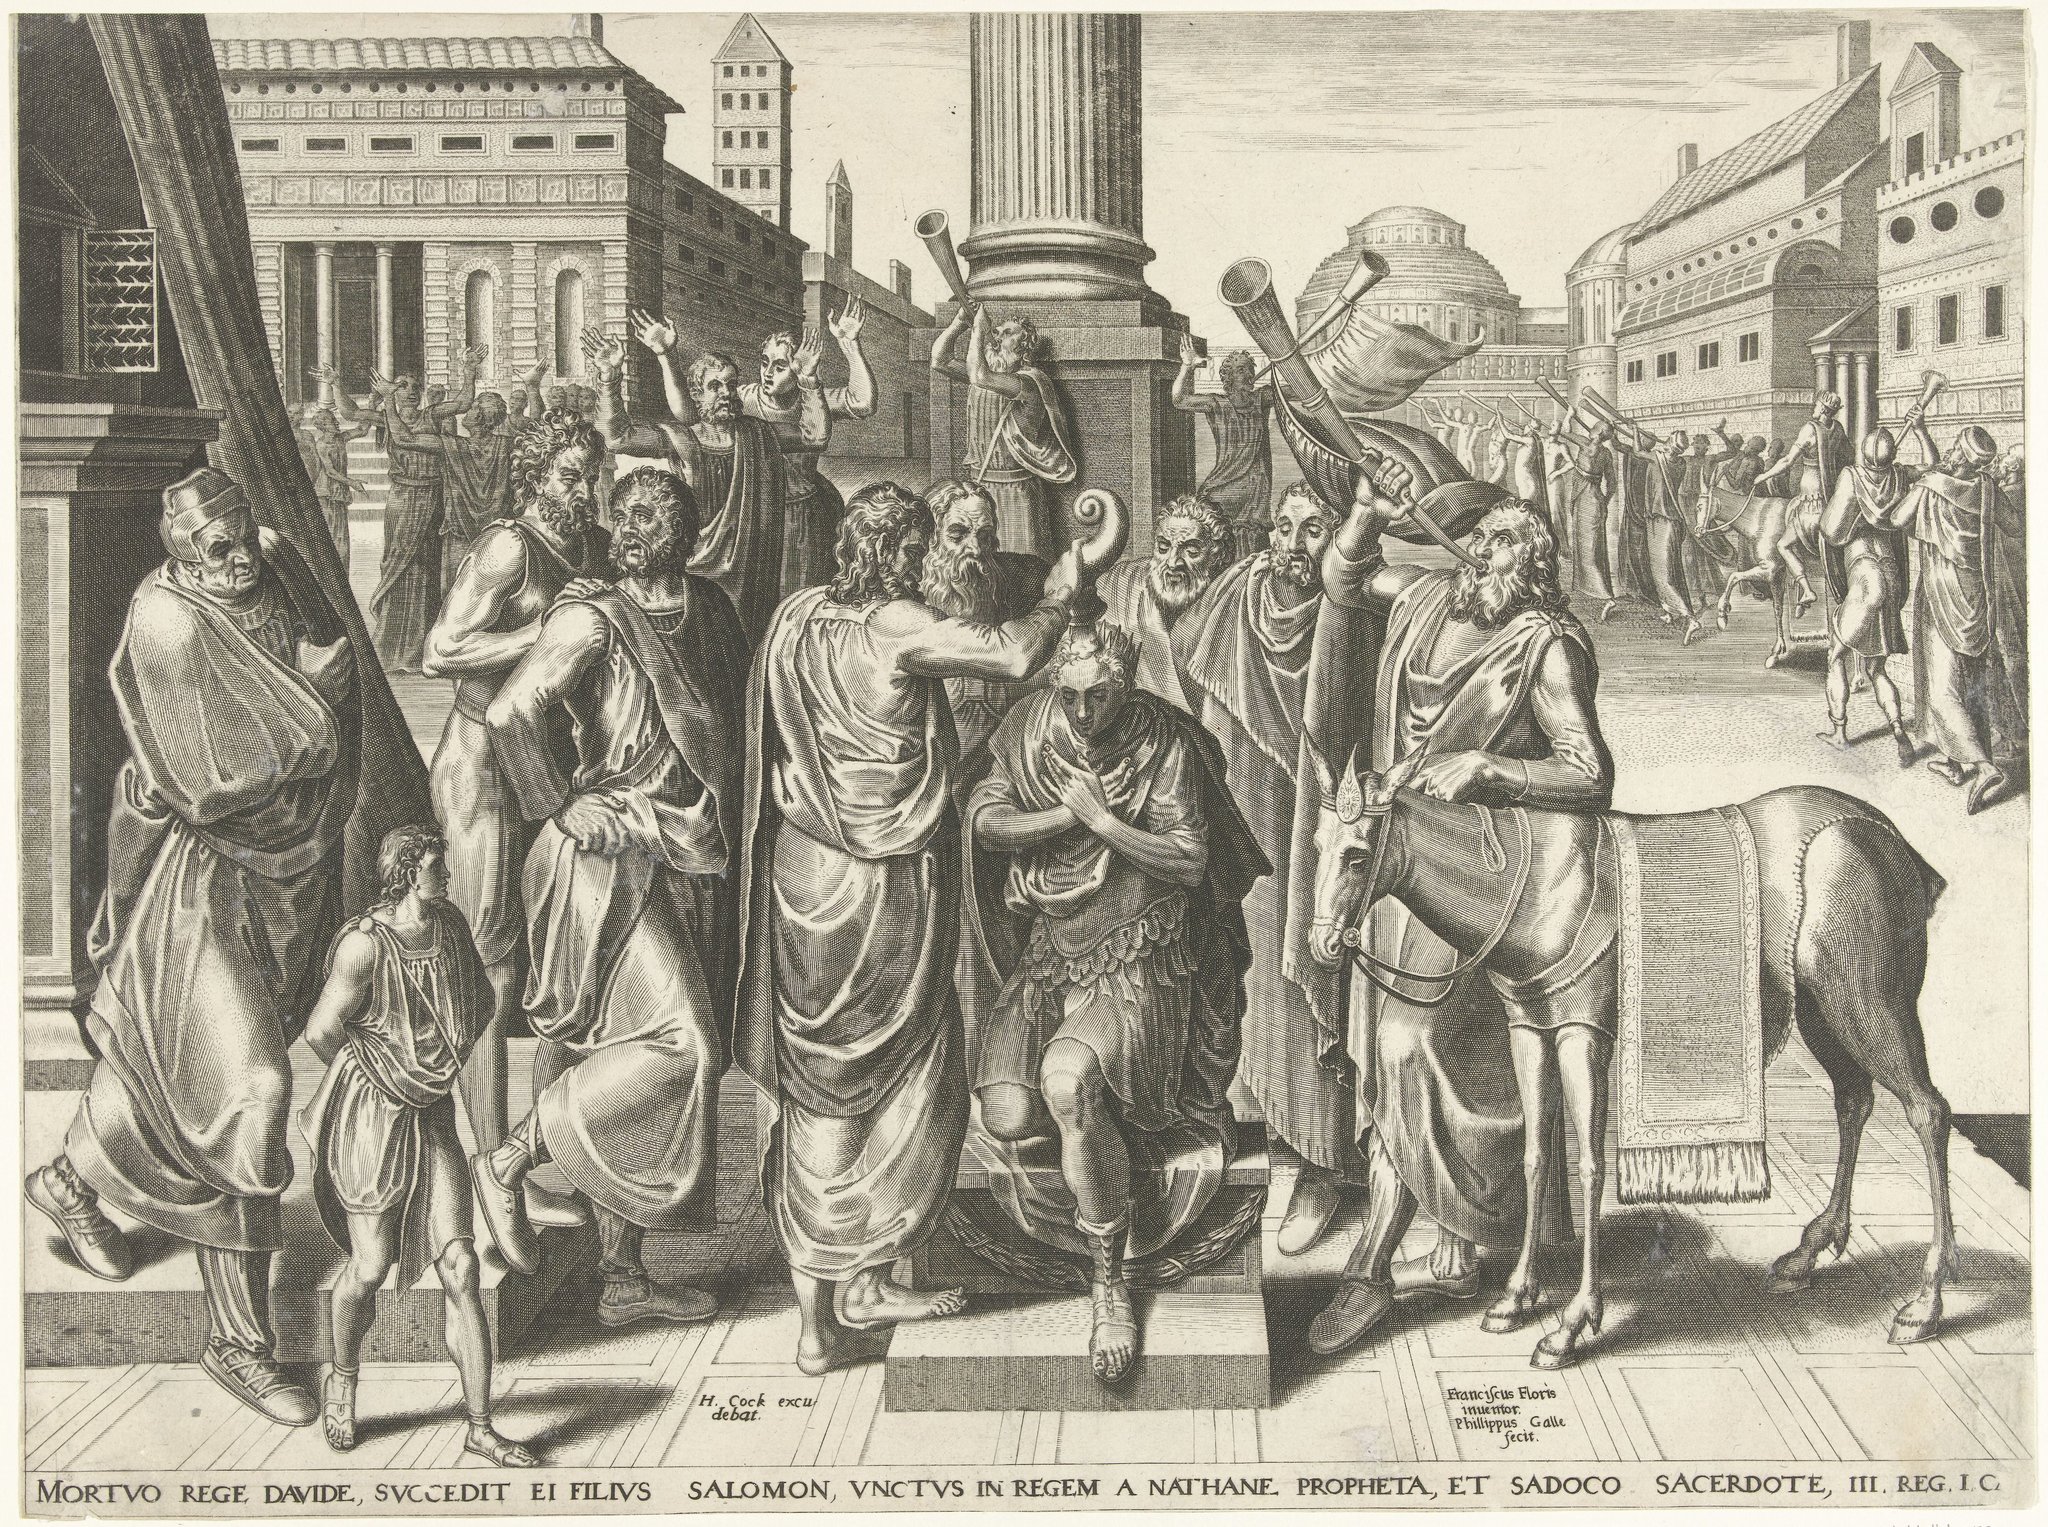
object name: print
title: Zalving van koning Salomon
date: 1557-1570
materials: paper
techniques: engraving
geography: haarlem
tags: solomon anointed king by zadok; all the people rejoice and blow their trumpets, crowning of solomon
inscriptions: collector's mark: Lugt 2228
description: De priester Sadok zalft Salomon op een plein voor de tempel met olie. Salomon staat op een bordes van twee treden en knielt voorover. Het volk juicht en veel mannen blazen als teken van vreugde op ramshoorns.